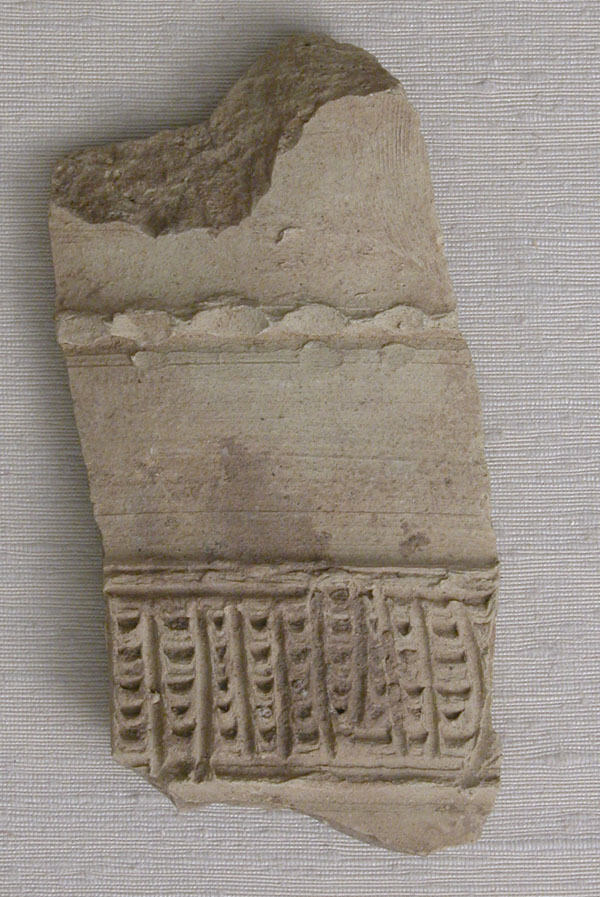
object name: fragment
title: Ceramic Fragment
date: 701-900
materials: earthenware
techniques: incising, molding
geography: iraq